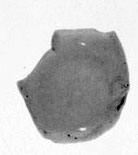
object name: fragment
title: Fragment of a Bowl (Study Collection)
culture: chinese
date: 1368-1911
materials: porcelain